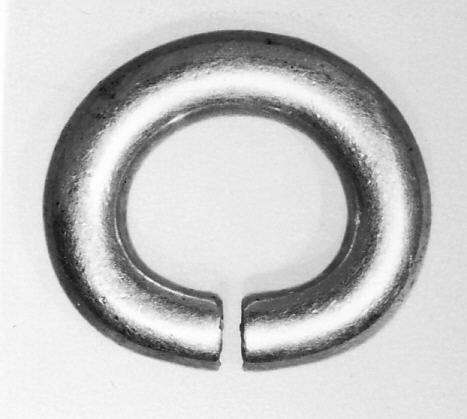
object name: earring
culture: japanese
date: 501-600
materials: gilt bronze